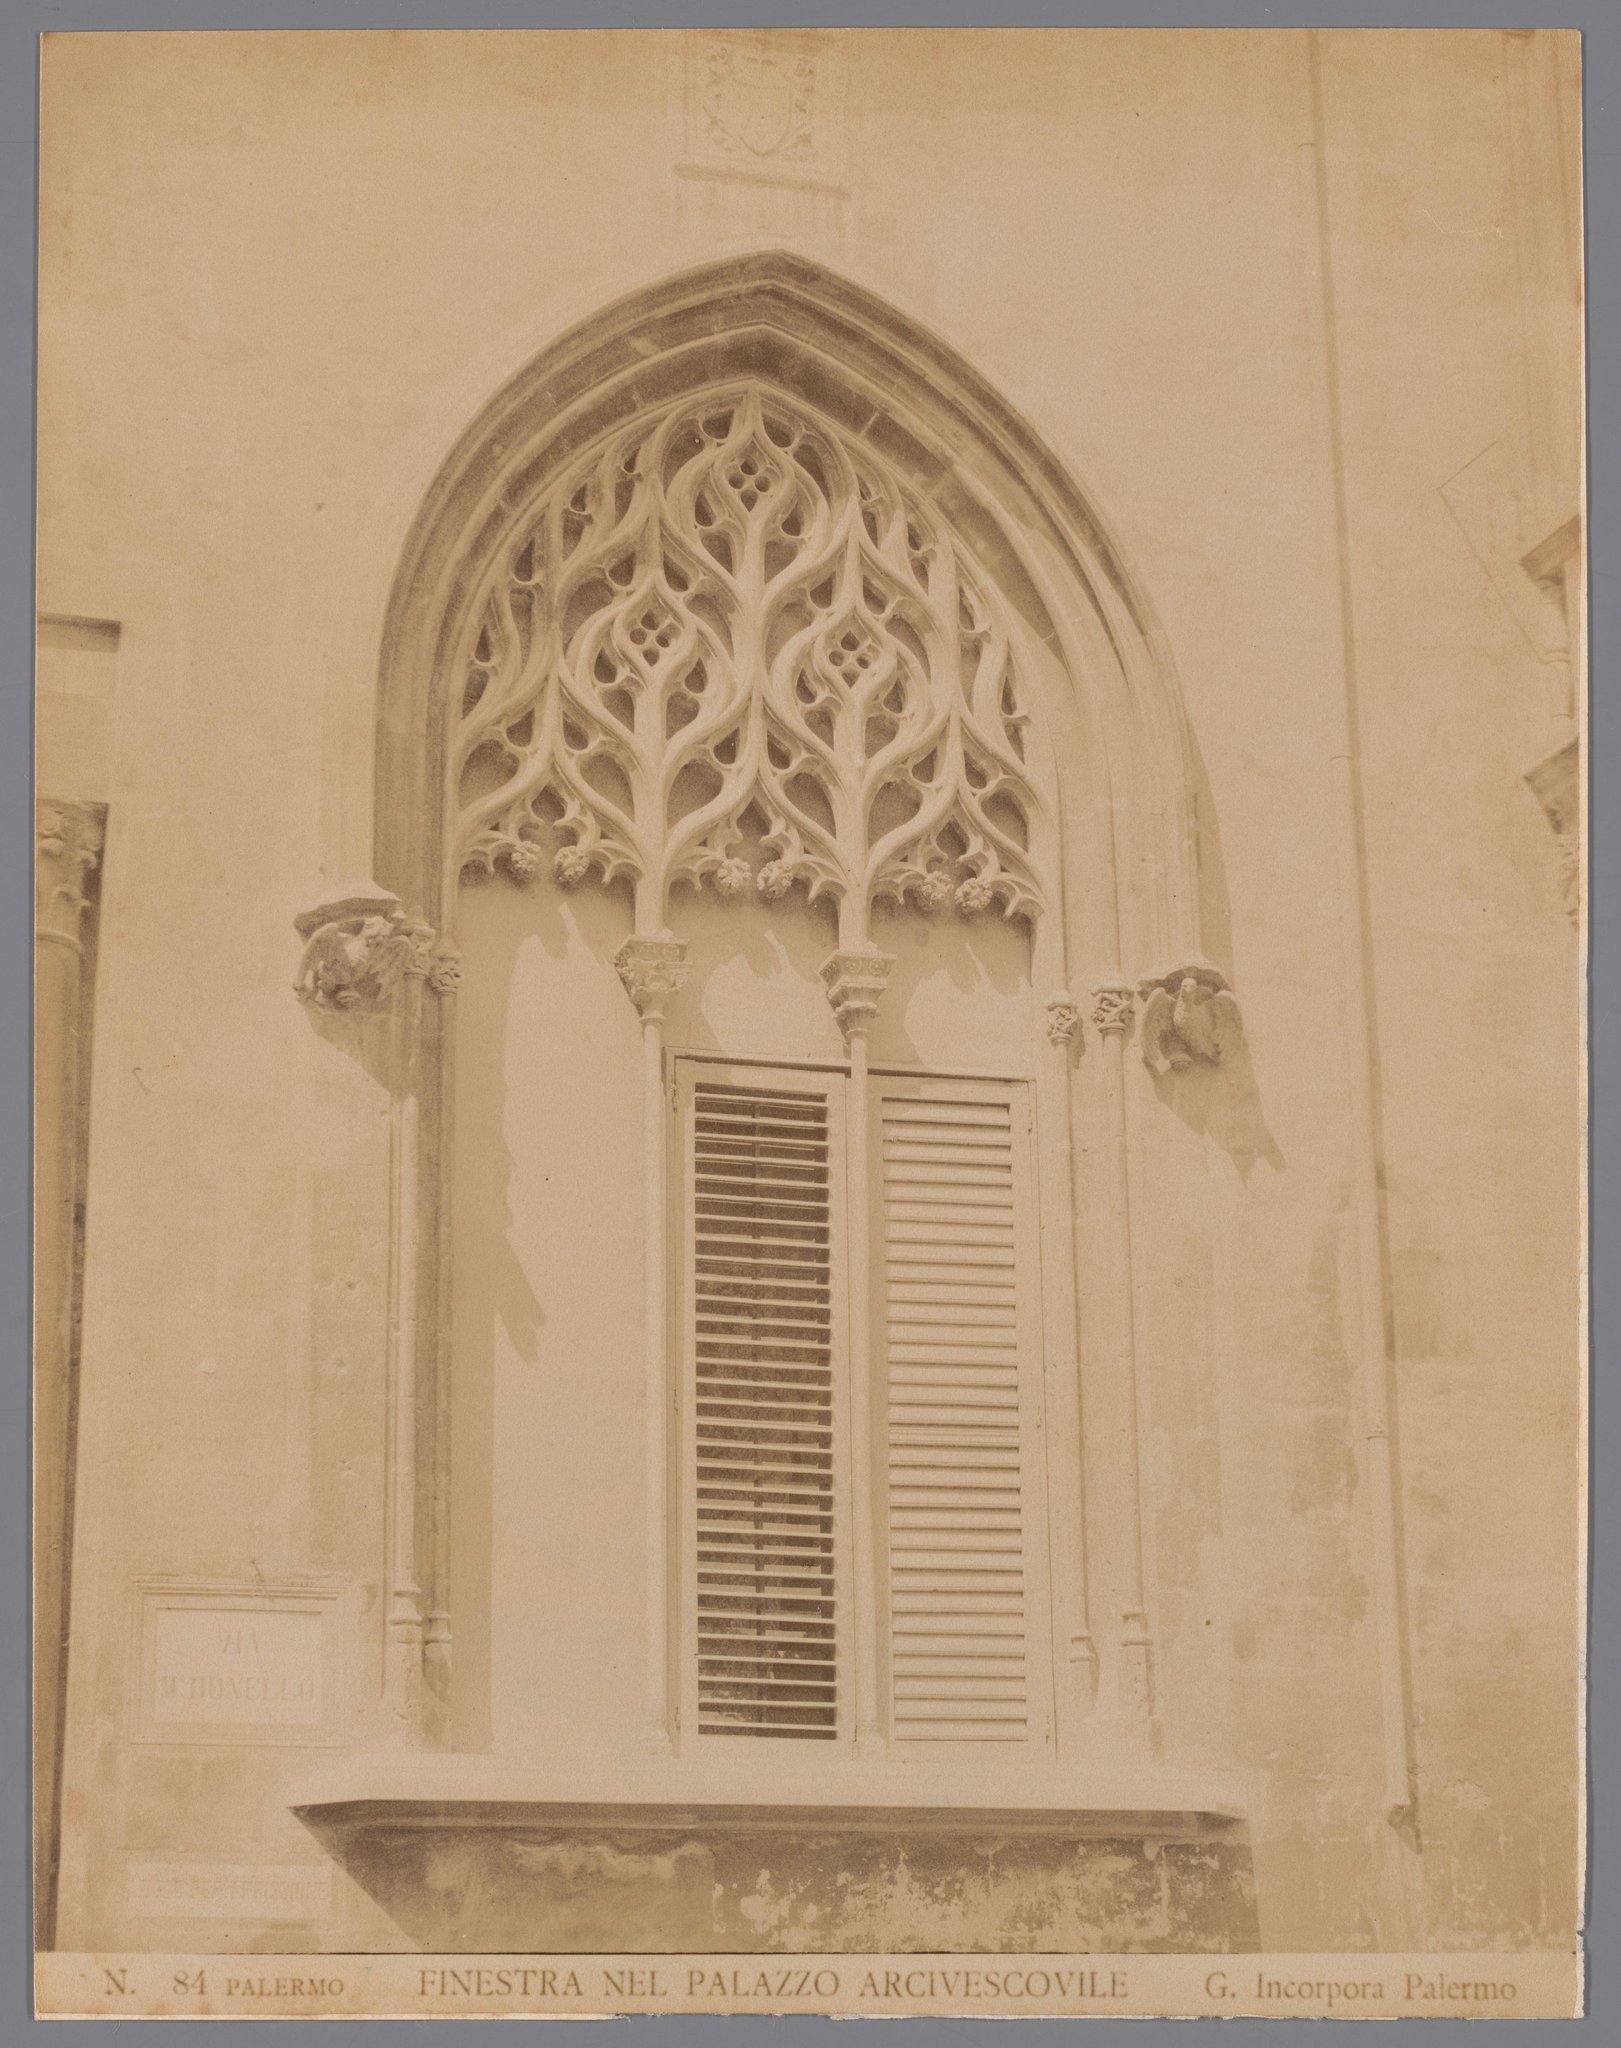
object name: photograph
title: Venster van het aartsbisschoppelijk paleis in Palermo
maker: giuseppe incorpora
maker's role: fotograaf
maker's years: 1834-1914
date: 1856-1914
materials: paper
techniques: albumen print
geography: palermo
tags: palace, closed window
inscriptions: number: ‘N. 84’